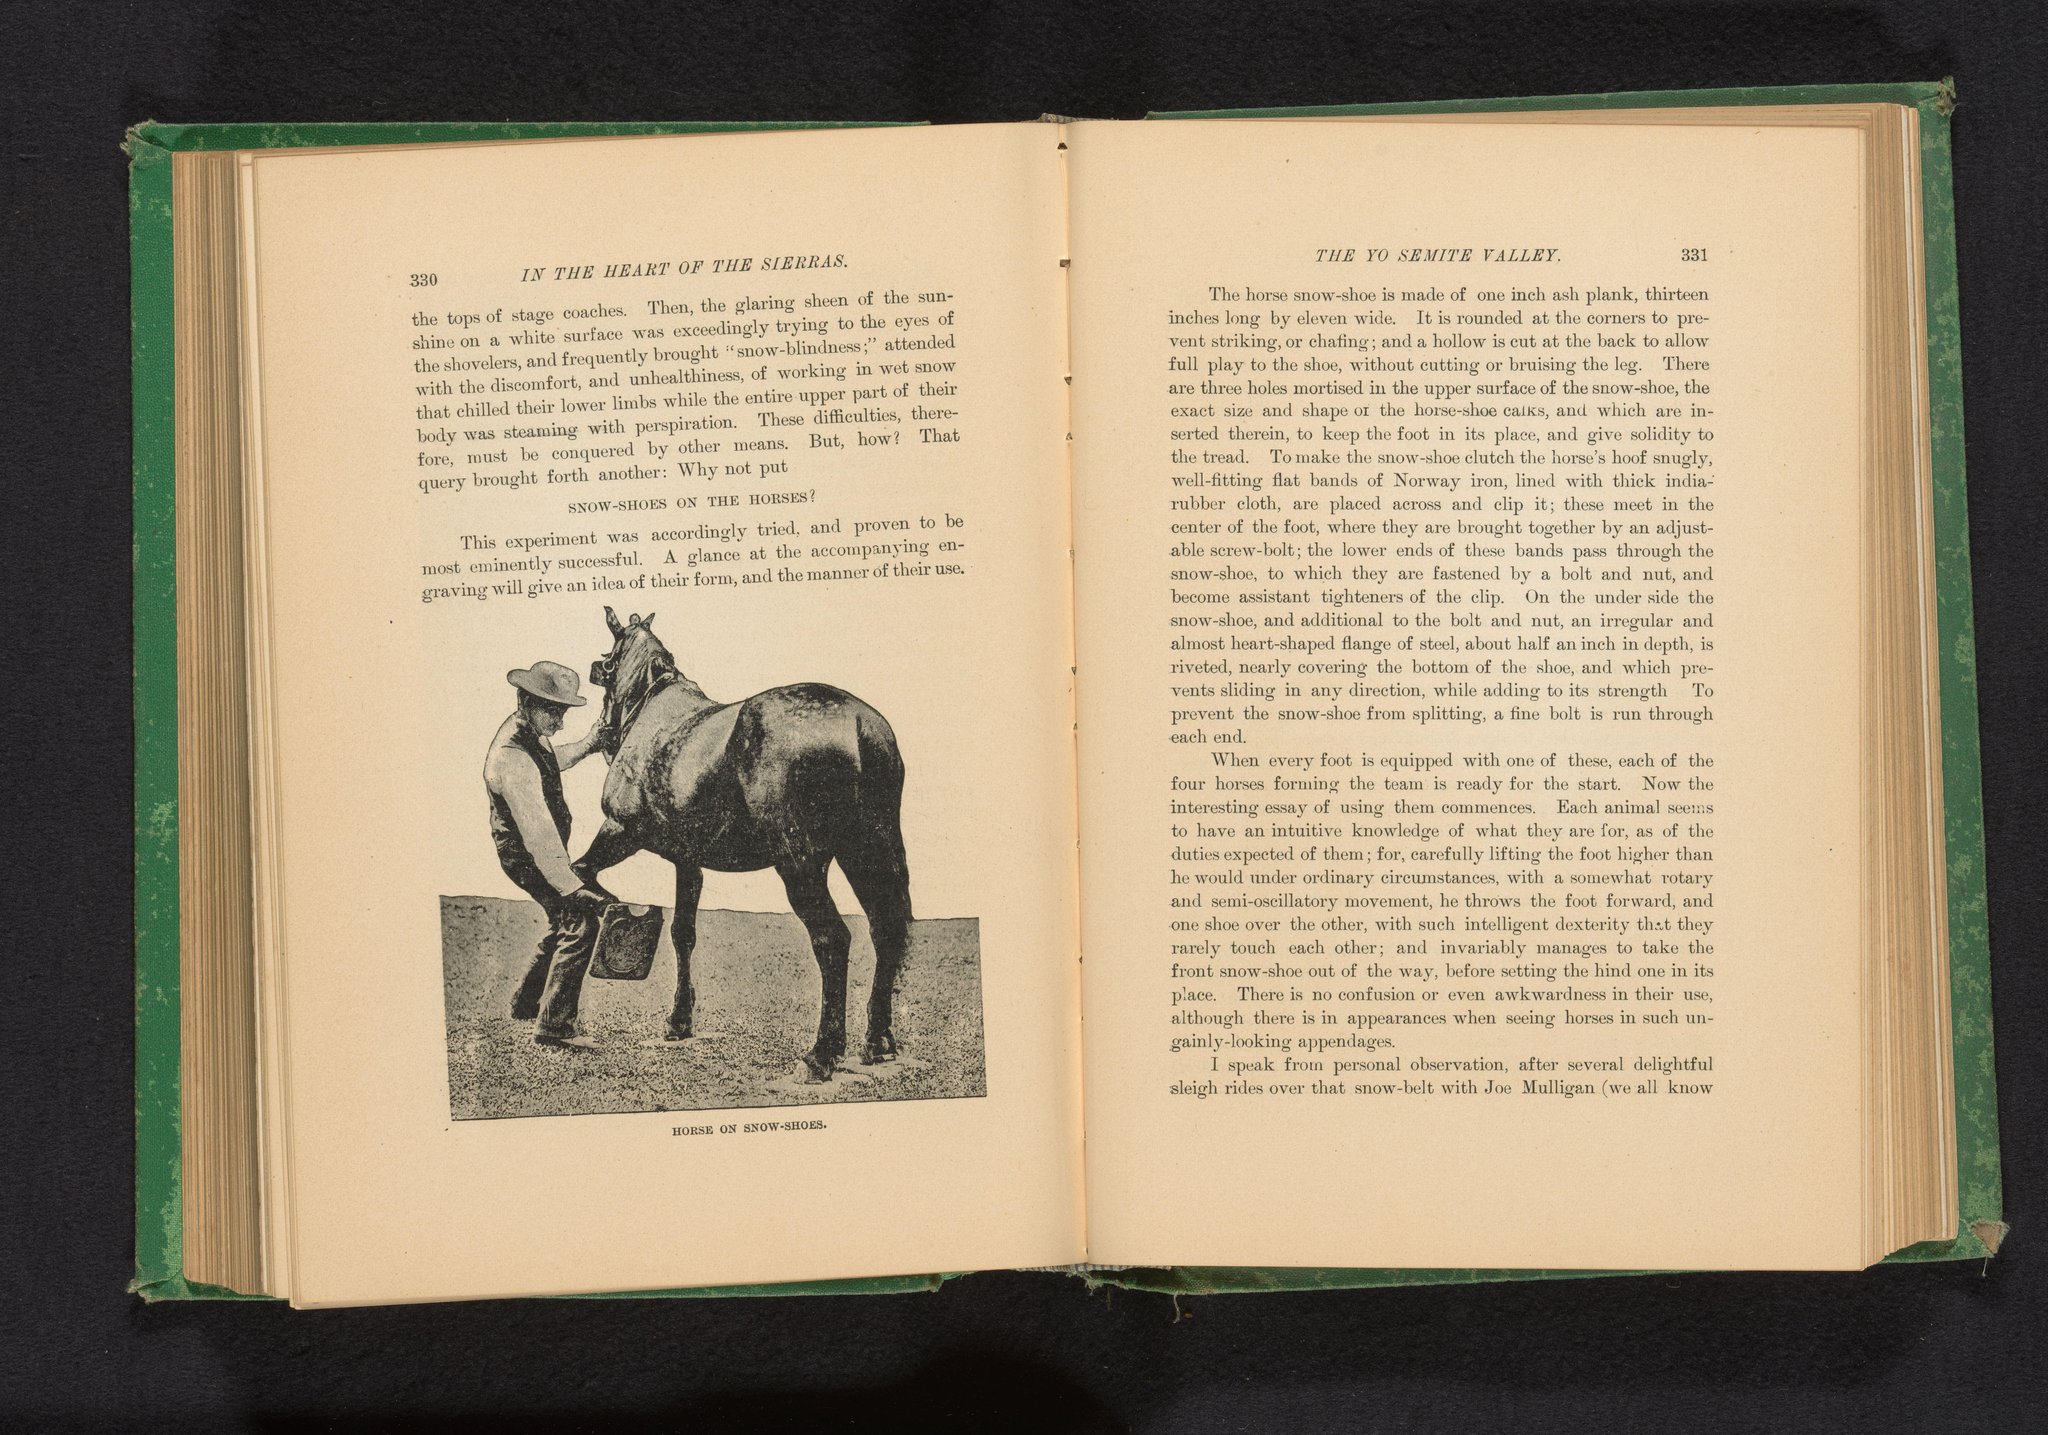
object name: photomechanical print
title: Man doet een paard sneeuwschoenen aan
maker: Anonymous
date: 1881-1886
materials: paper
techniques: printing block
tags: snow-shoes, horse